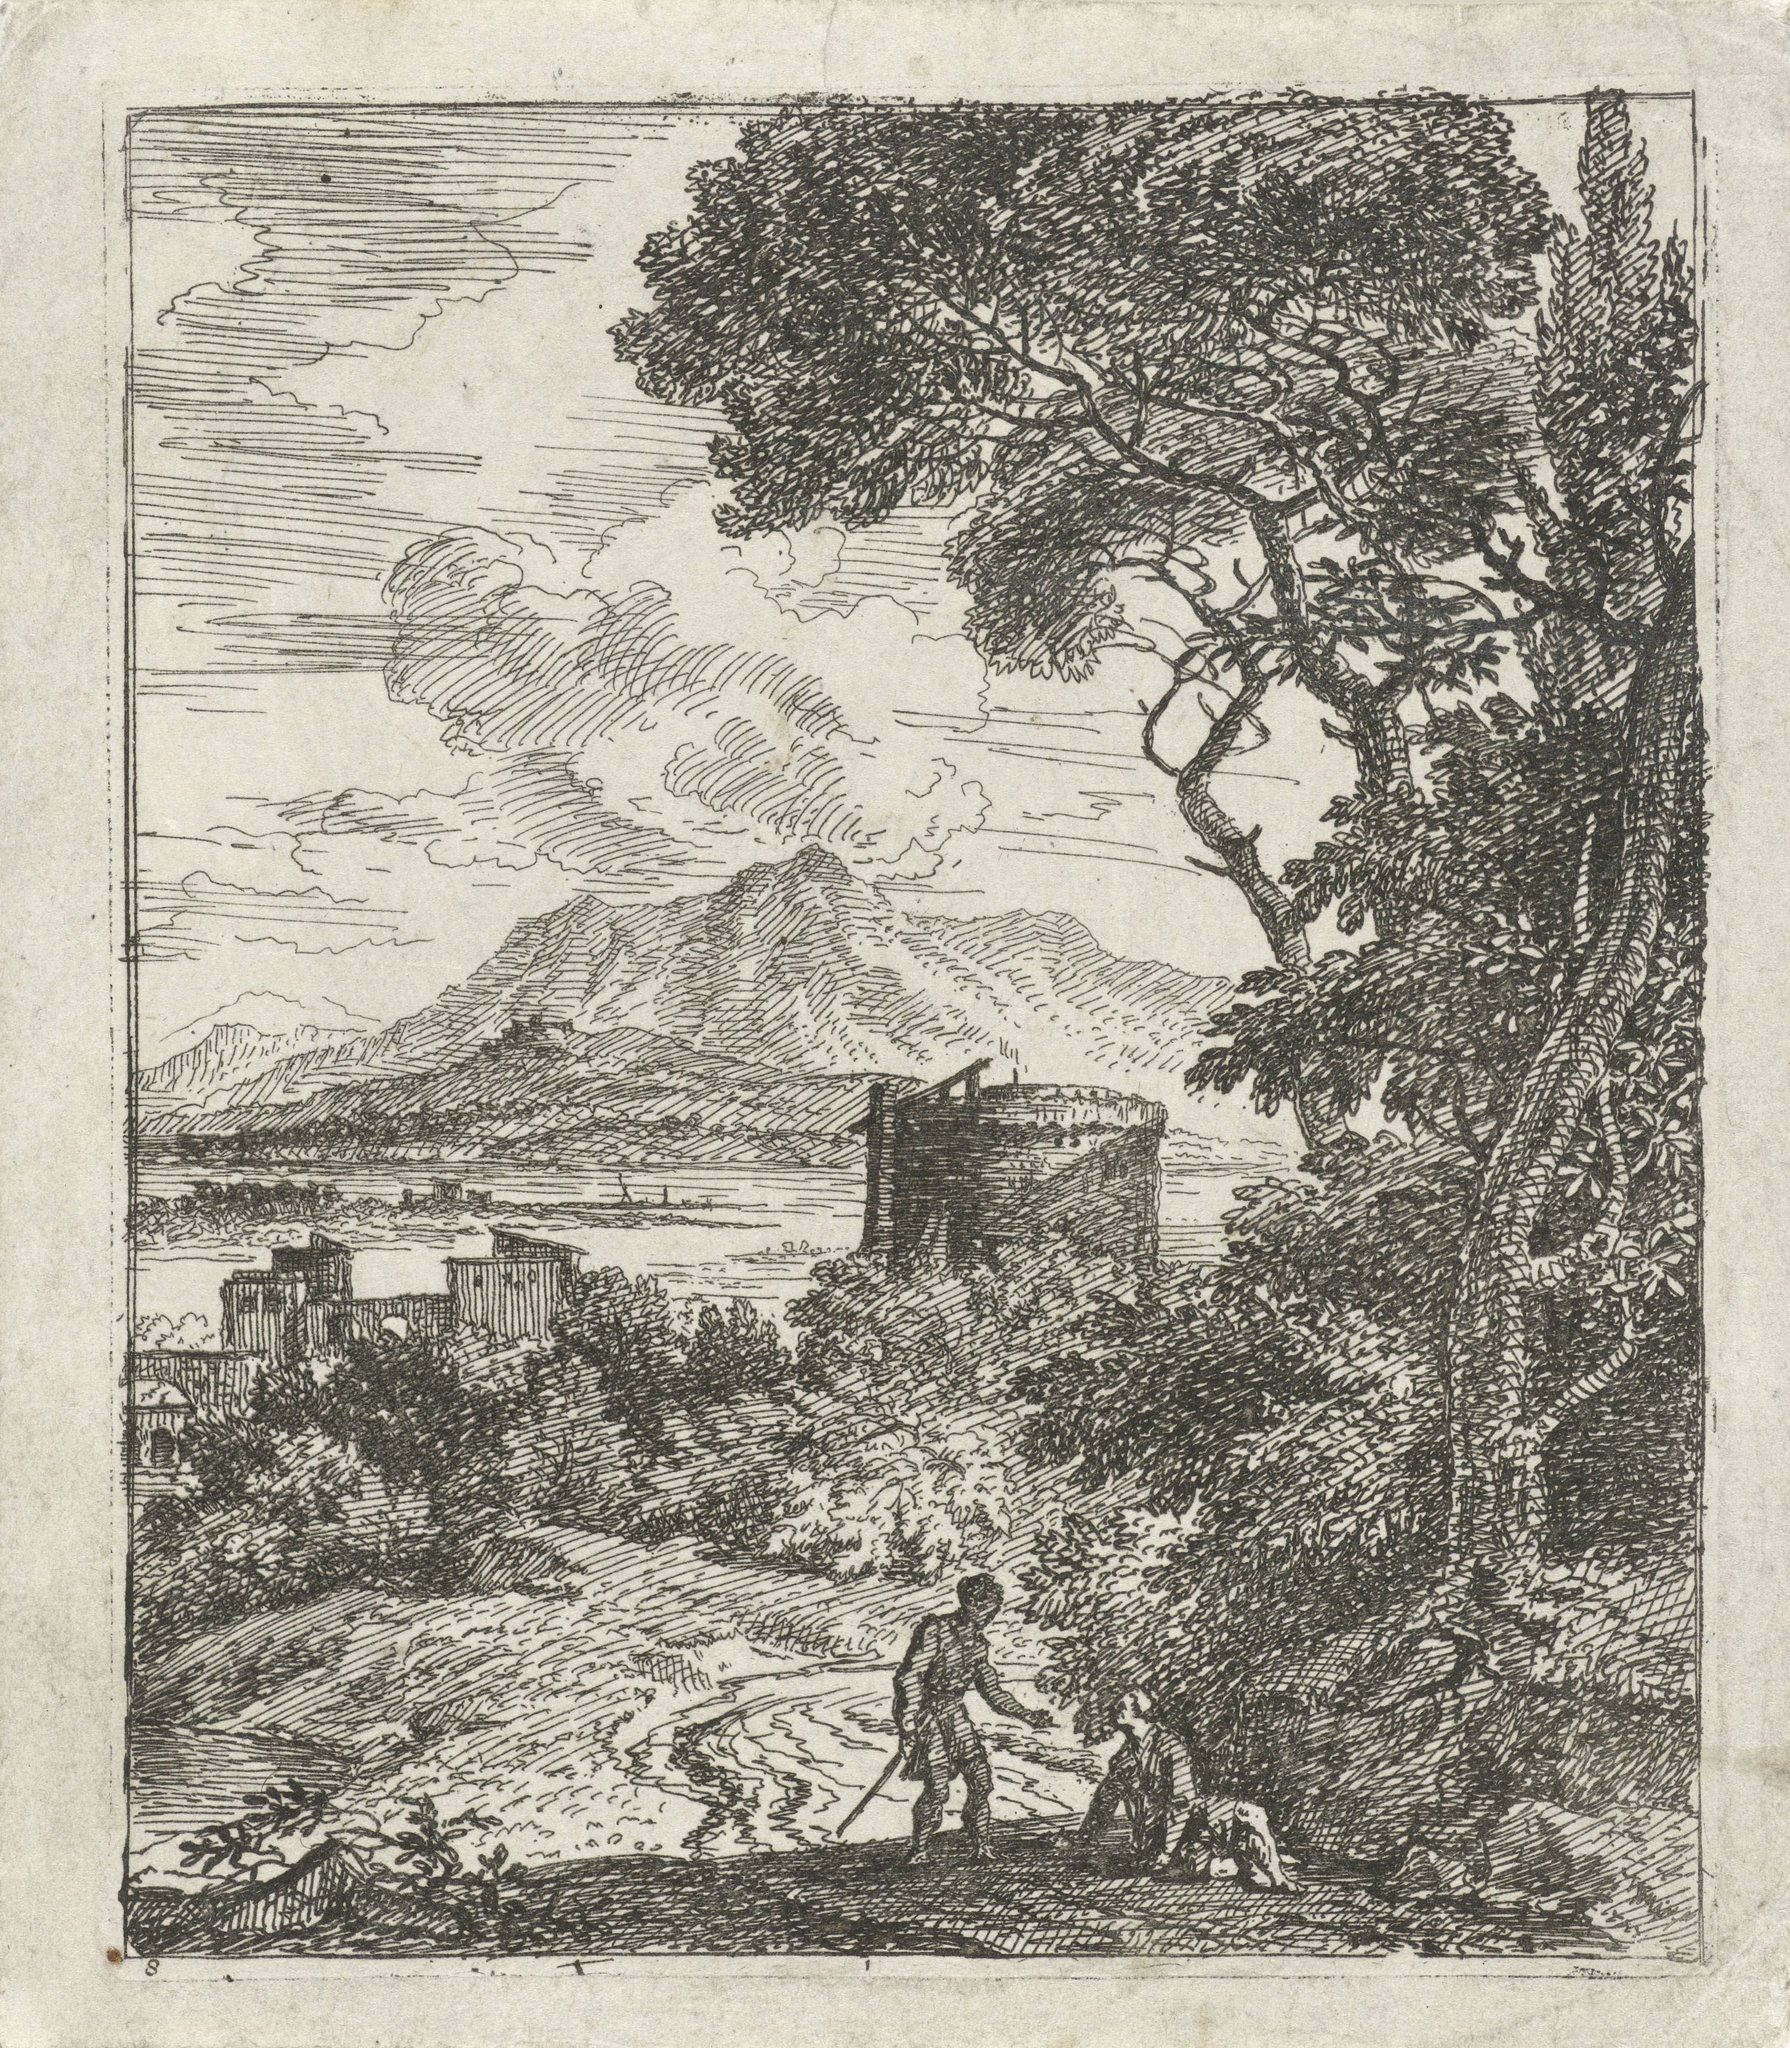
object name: print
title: Landschap met twee mannen op een weg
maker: jan van der meer (ii)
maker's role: draughtsman, print maker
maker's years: 1656-1705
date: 1673-1705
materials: paper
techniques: etching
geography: haarlem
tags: standing figure (+ speaking), road, path, sitting on the ground, mountains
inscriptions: collector's mark: Lugt 2228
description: Op een landweg spreekt een man een zittende figuur aan. Op de achtergrond gebouwen en bergen. Linksonder genummerd: 8.